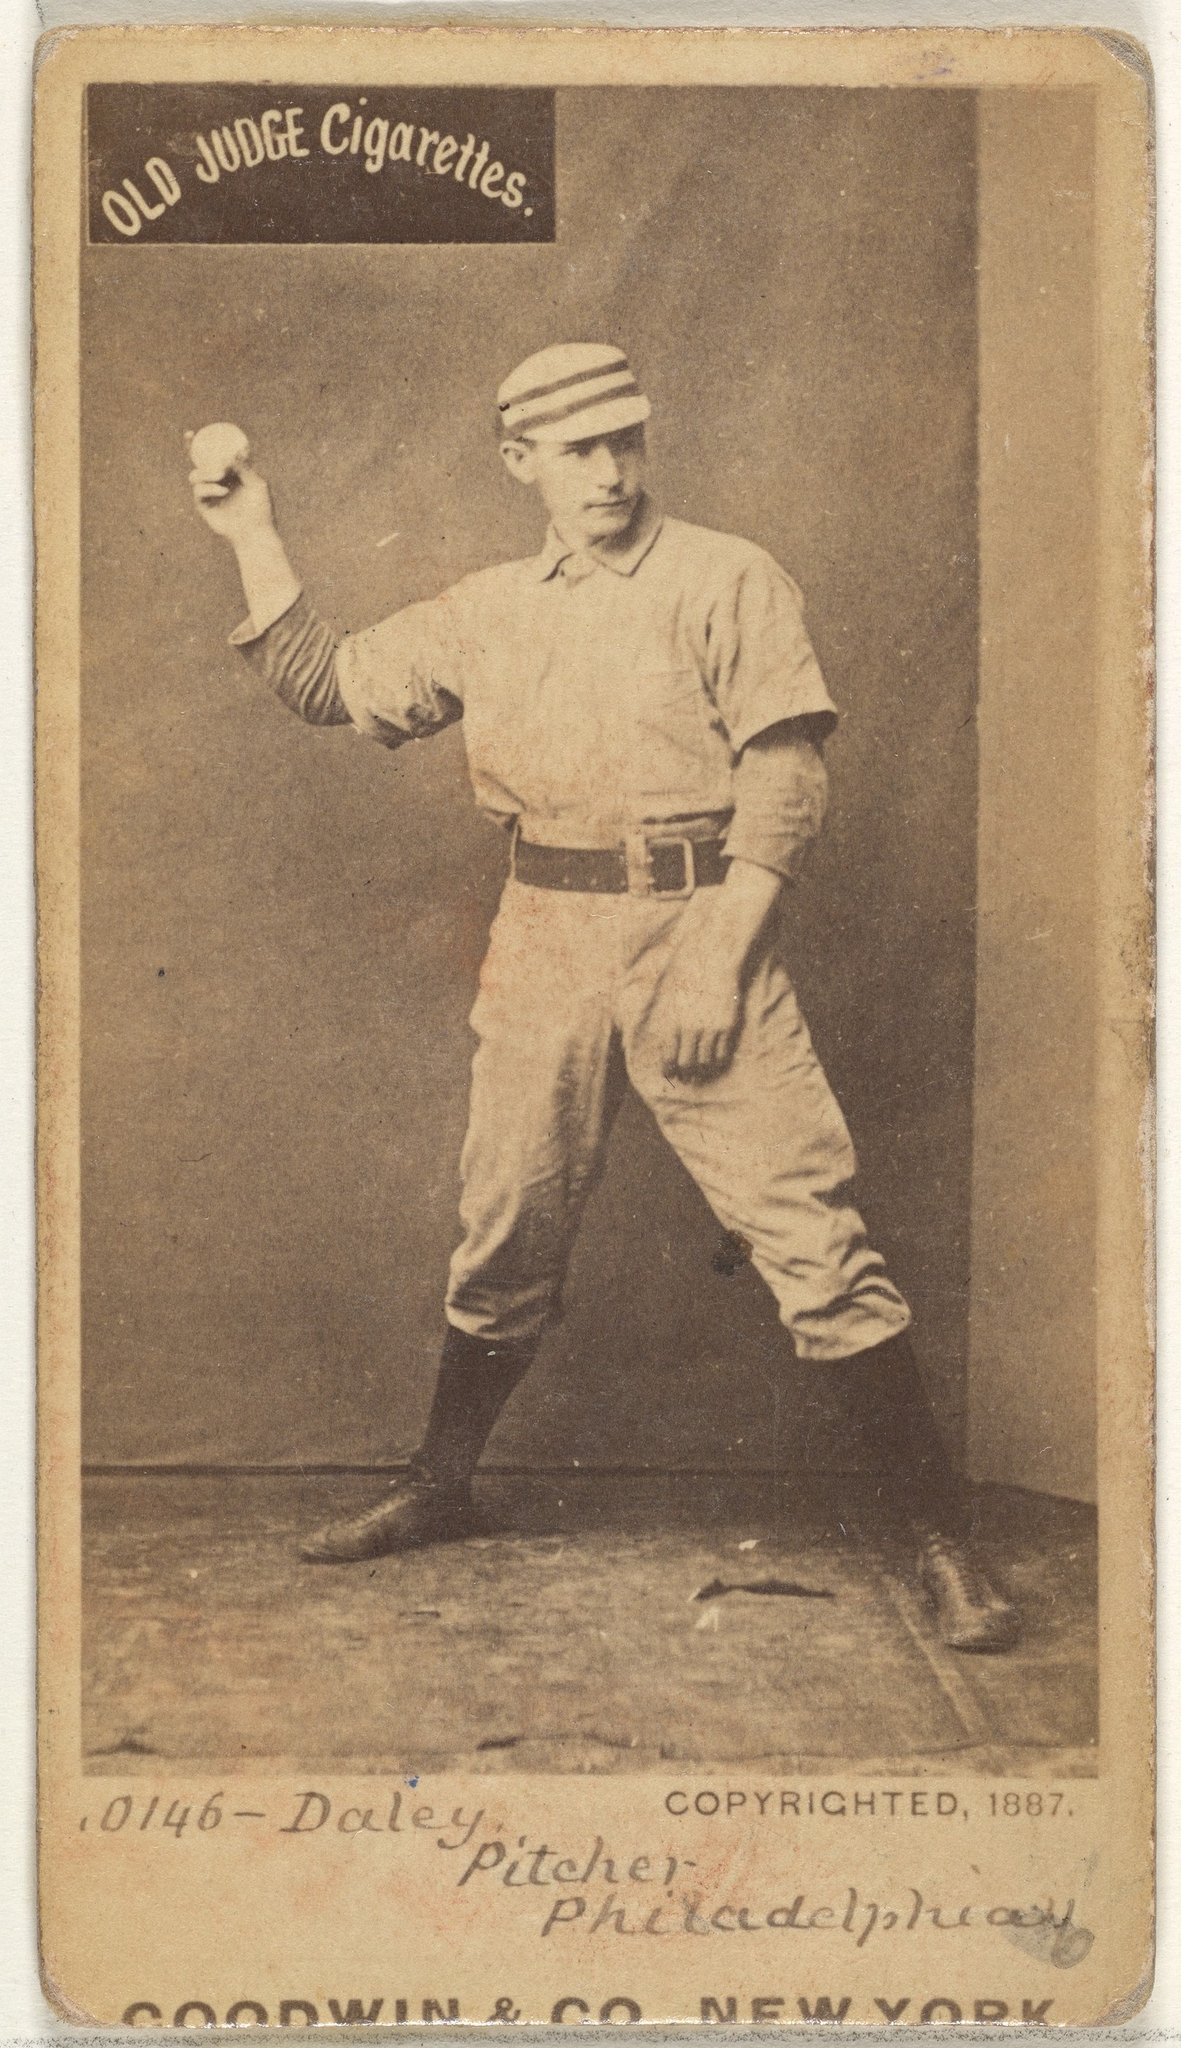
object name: baseball card, photograph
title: Edward M. Daily, Pitcher, Philadelphia, from the Old Judge series (N172) for Old Judge Cigarettes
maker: goodwin & company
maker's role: publisher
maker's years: 1850-1950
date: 1887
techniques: albumen silver print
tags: men,portraits,baseball,athletes